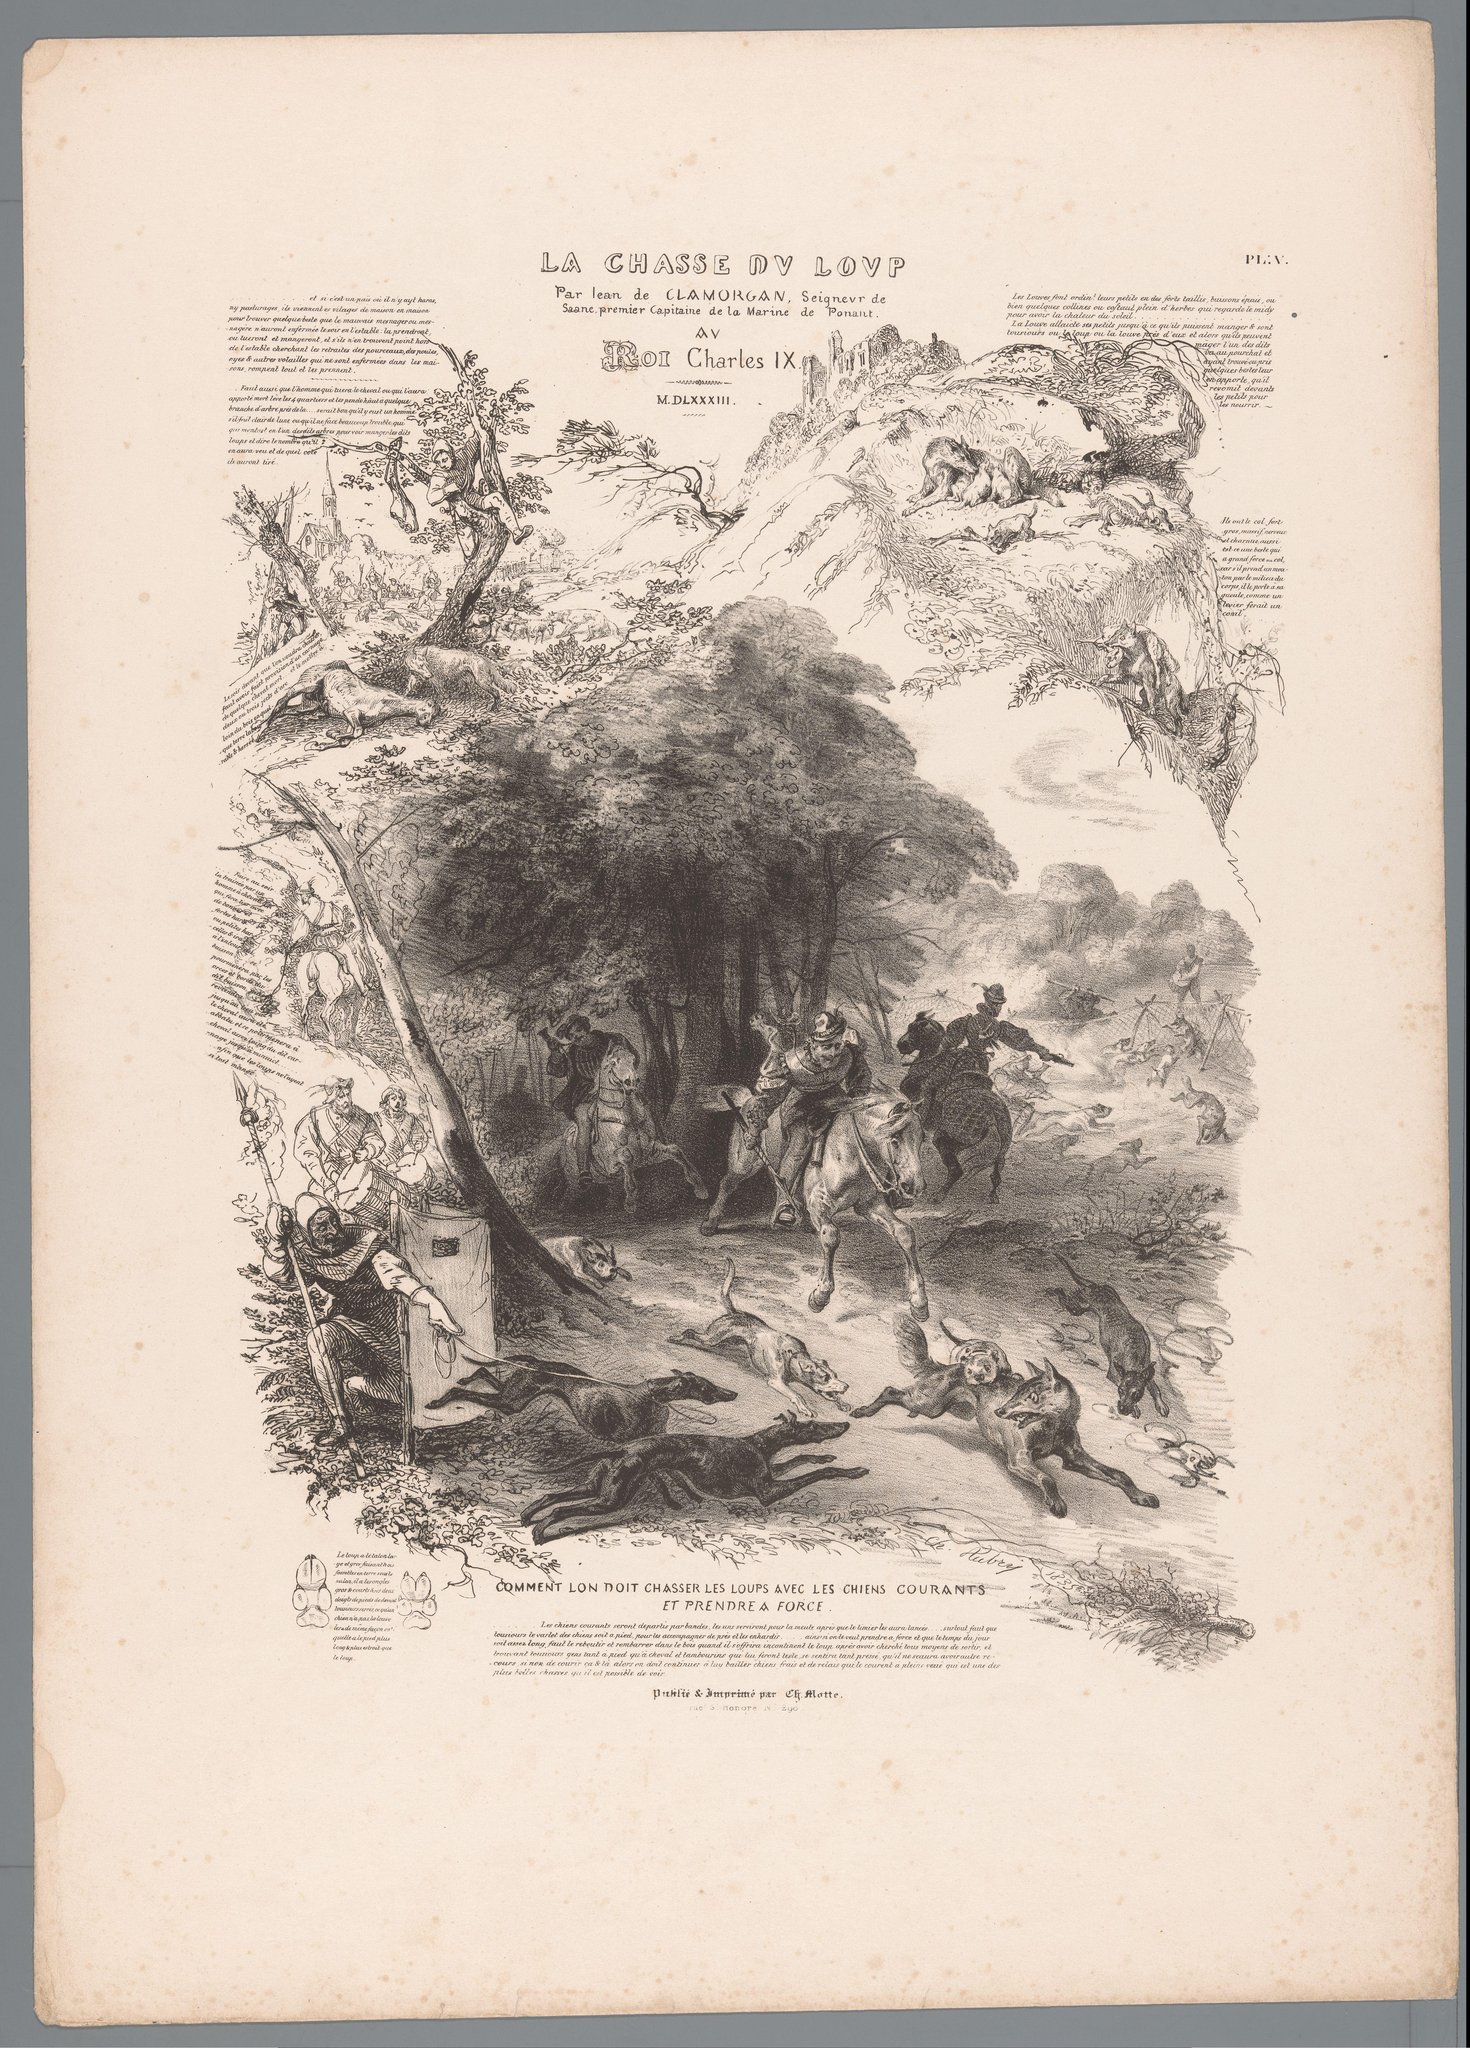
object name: print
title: La chasse du loup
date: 1835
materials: paper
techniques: lithography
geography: paris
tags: hunting dogs, hunt ~ predatory animals (fox, lion), hunters hunting (n.b.: in 1988-1990 this notation denoted the concept of 43c11421 'hunters resting during the hunt'), beasts of prey, predatory animals: wolf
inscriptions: check stamp: Lugt 1828c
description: Deze prent maakt deel uit van een omslag met twaalf prenten. Rondom de hoofdvoorstelling worden diverse jachttechnieken en wetenswaardigheden over de wolf uitgelegd in woord en beeld.